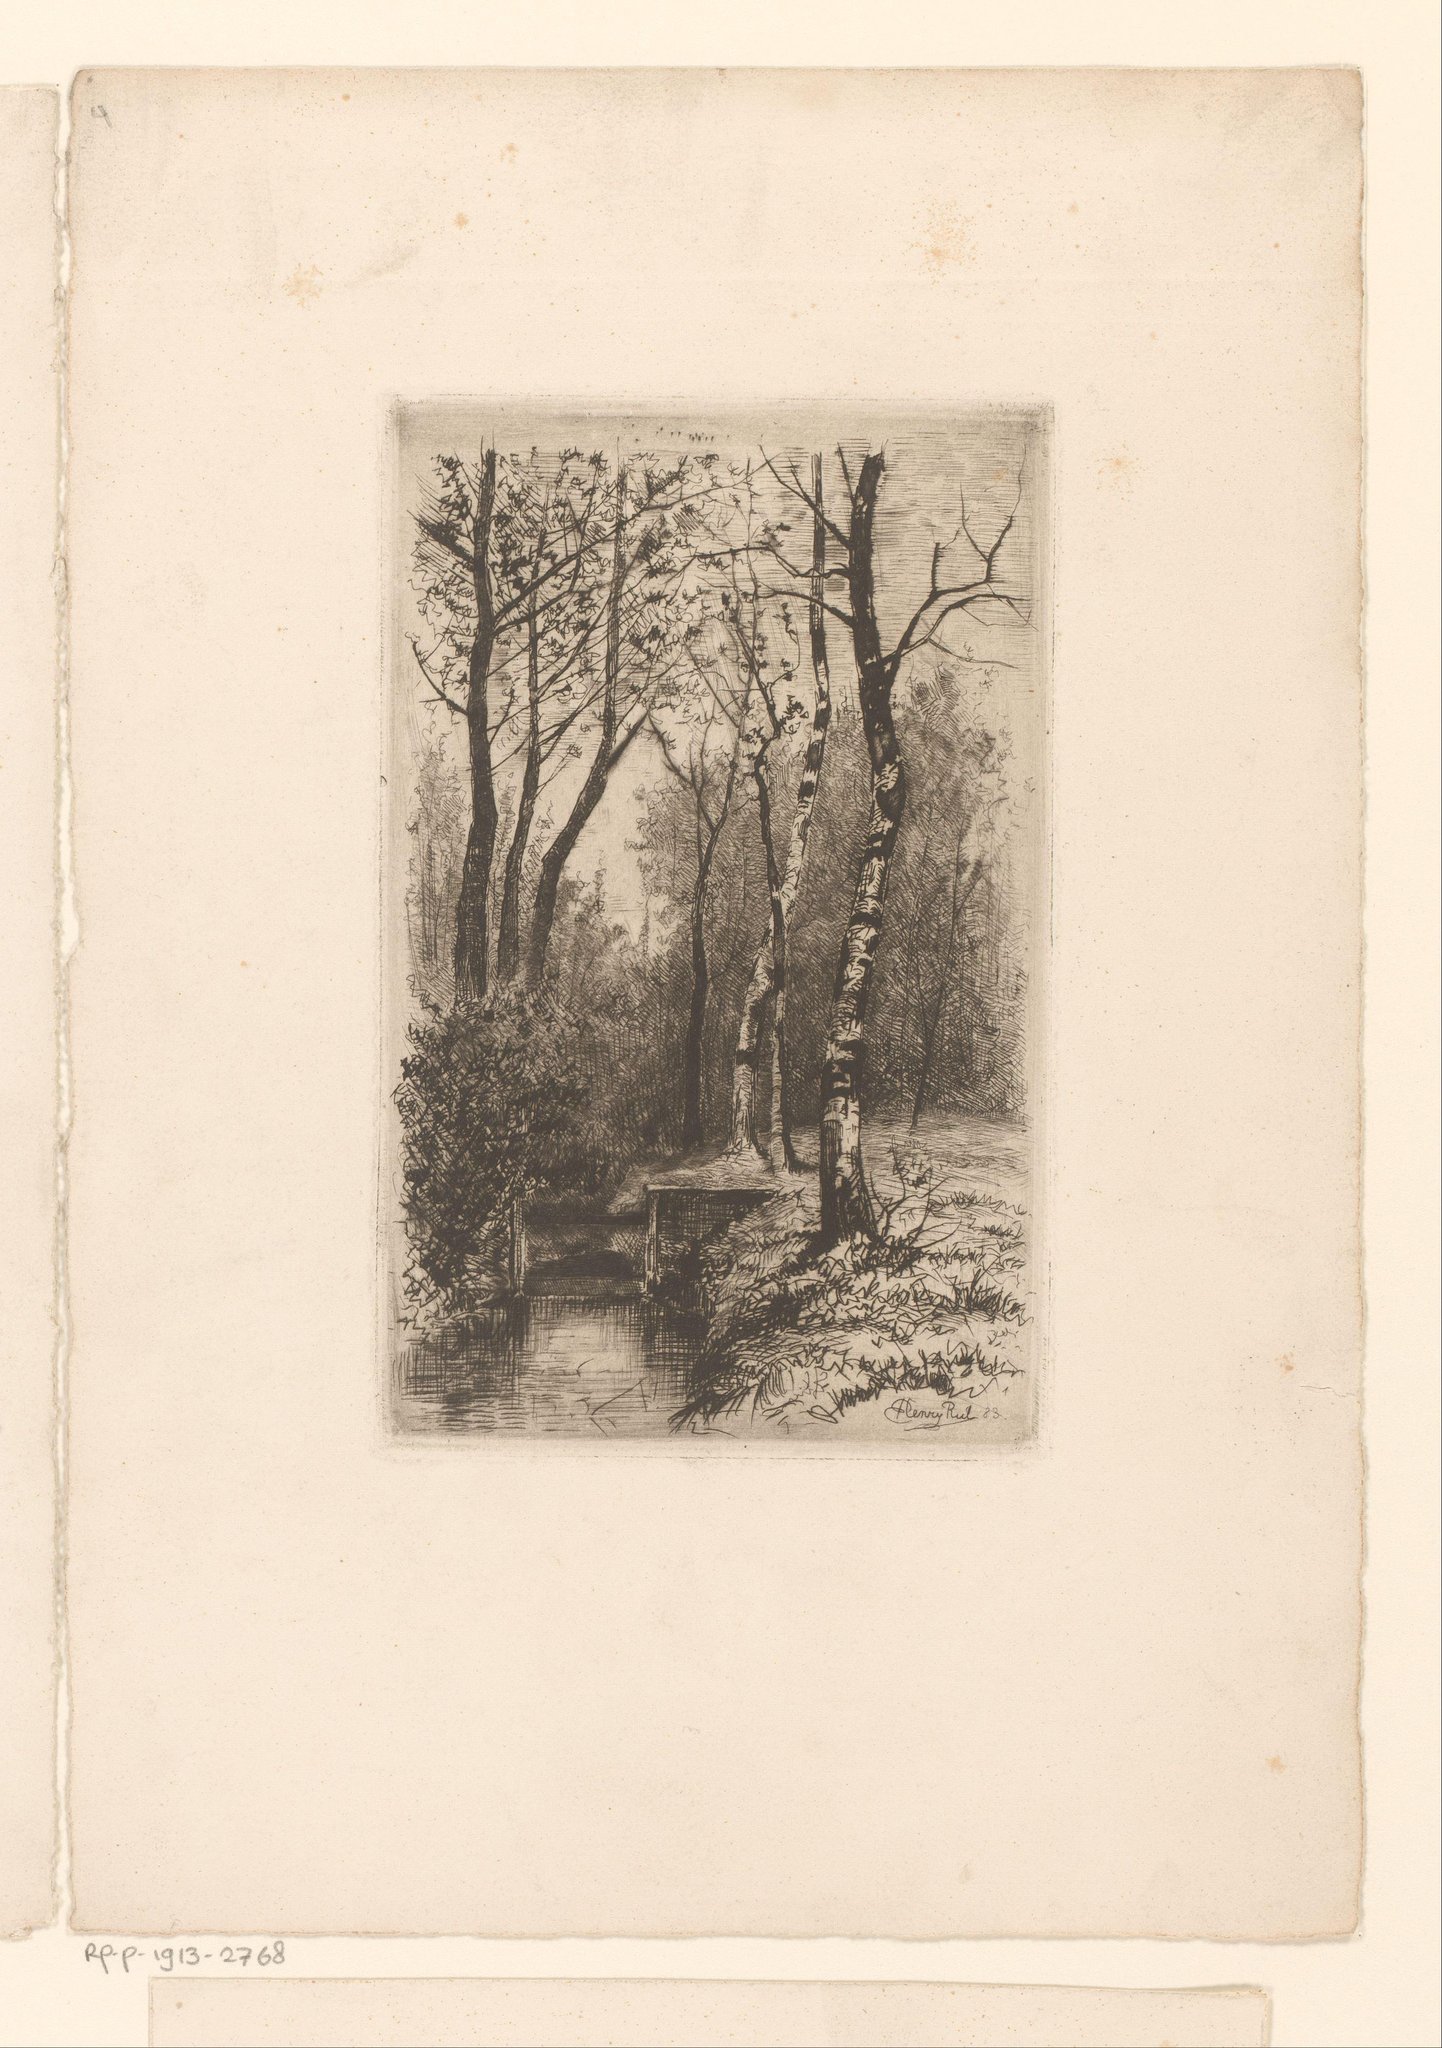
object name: print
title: Landschap met beek en berkenbomen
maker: henri rul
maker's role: print maker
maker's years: 1862-1942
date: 1883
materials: paper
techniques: drypoint, etching, intaglio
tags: brook, trees: birch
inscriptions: collector's mark: Lugt 2228